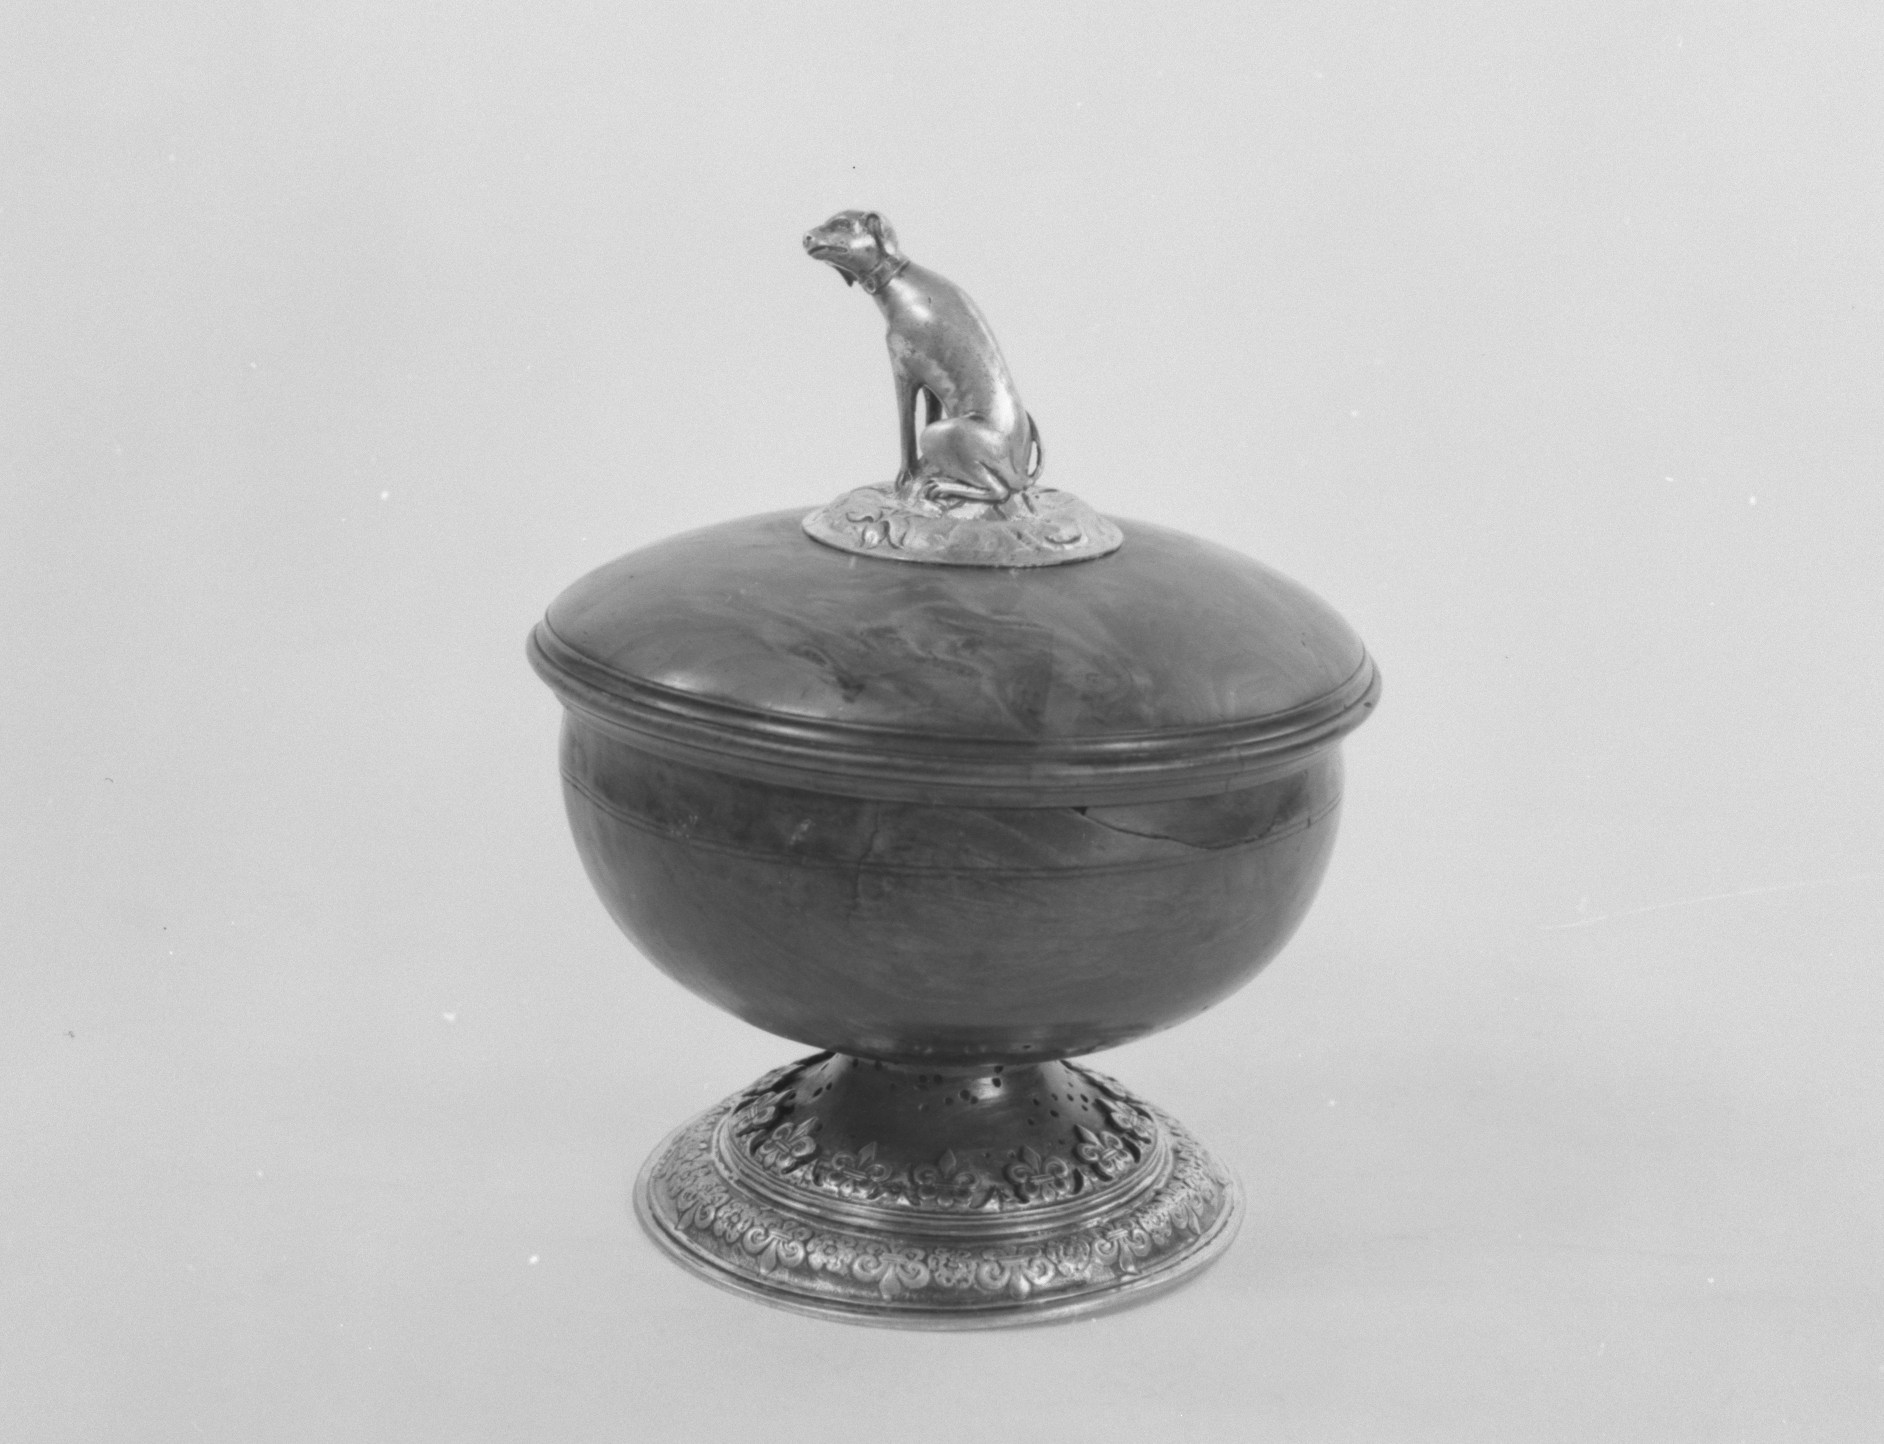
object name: mazer with cover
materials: wood, silver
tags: dogs